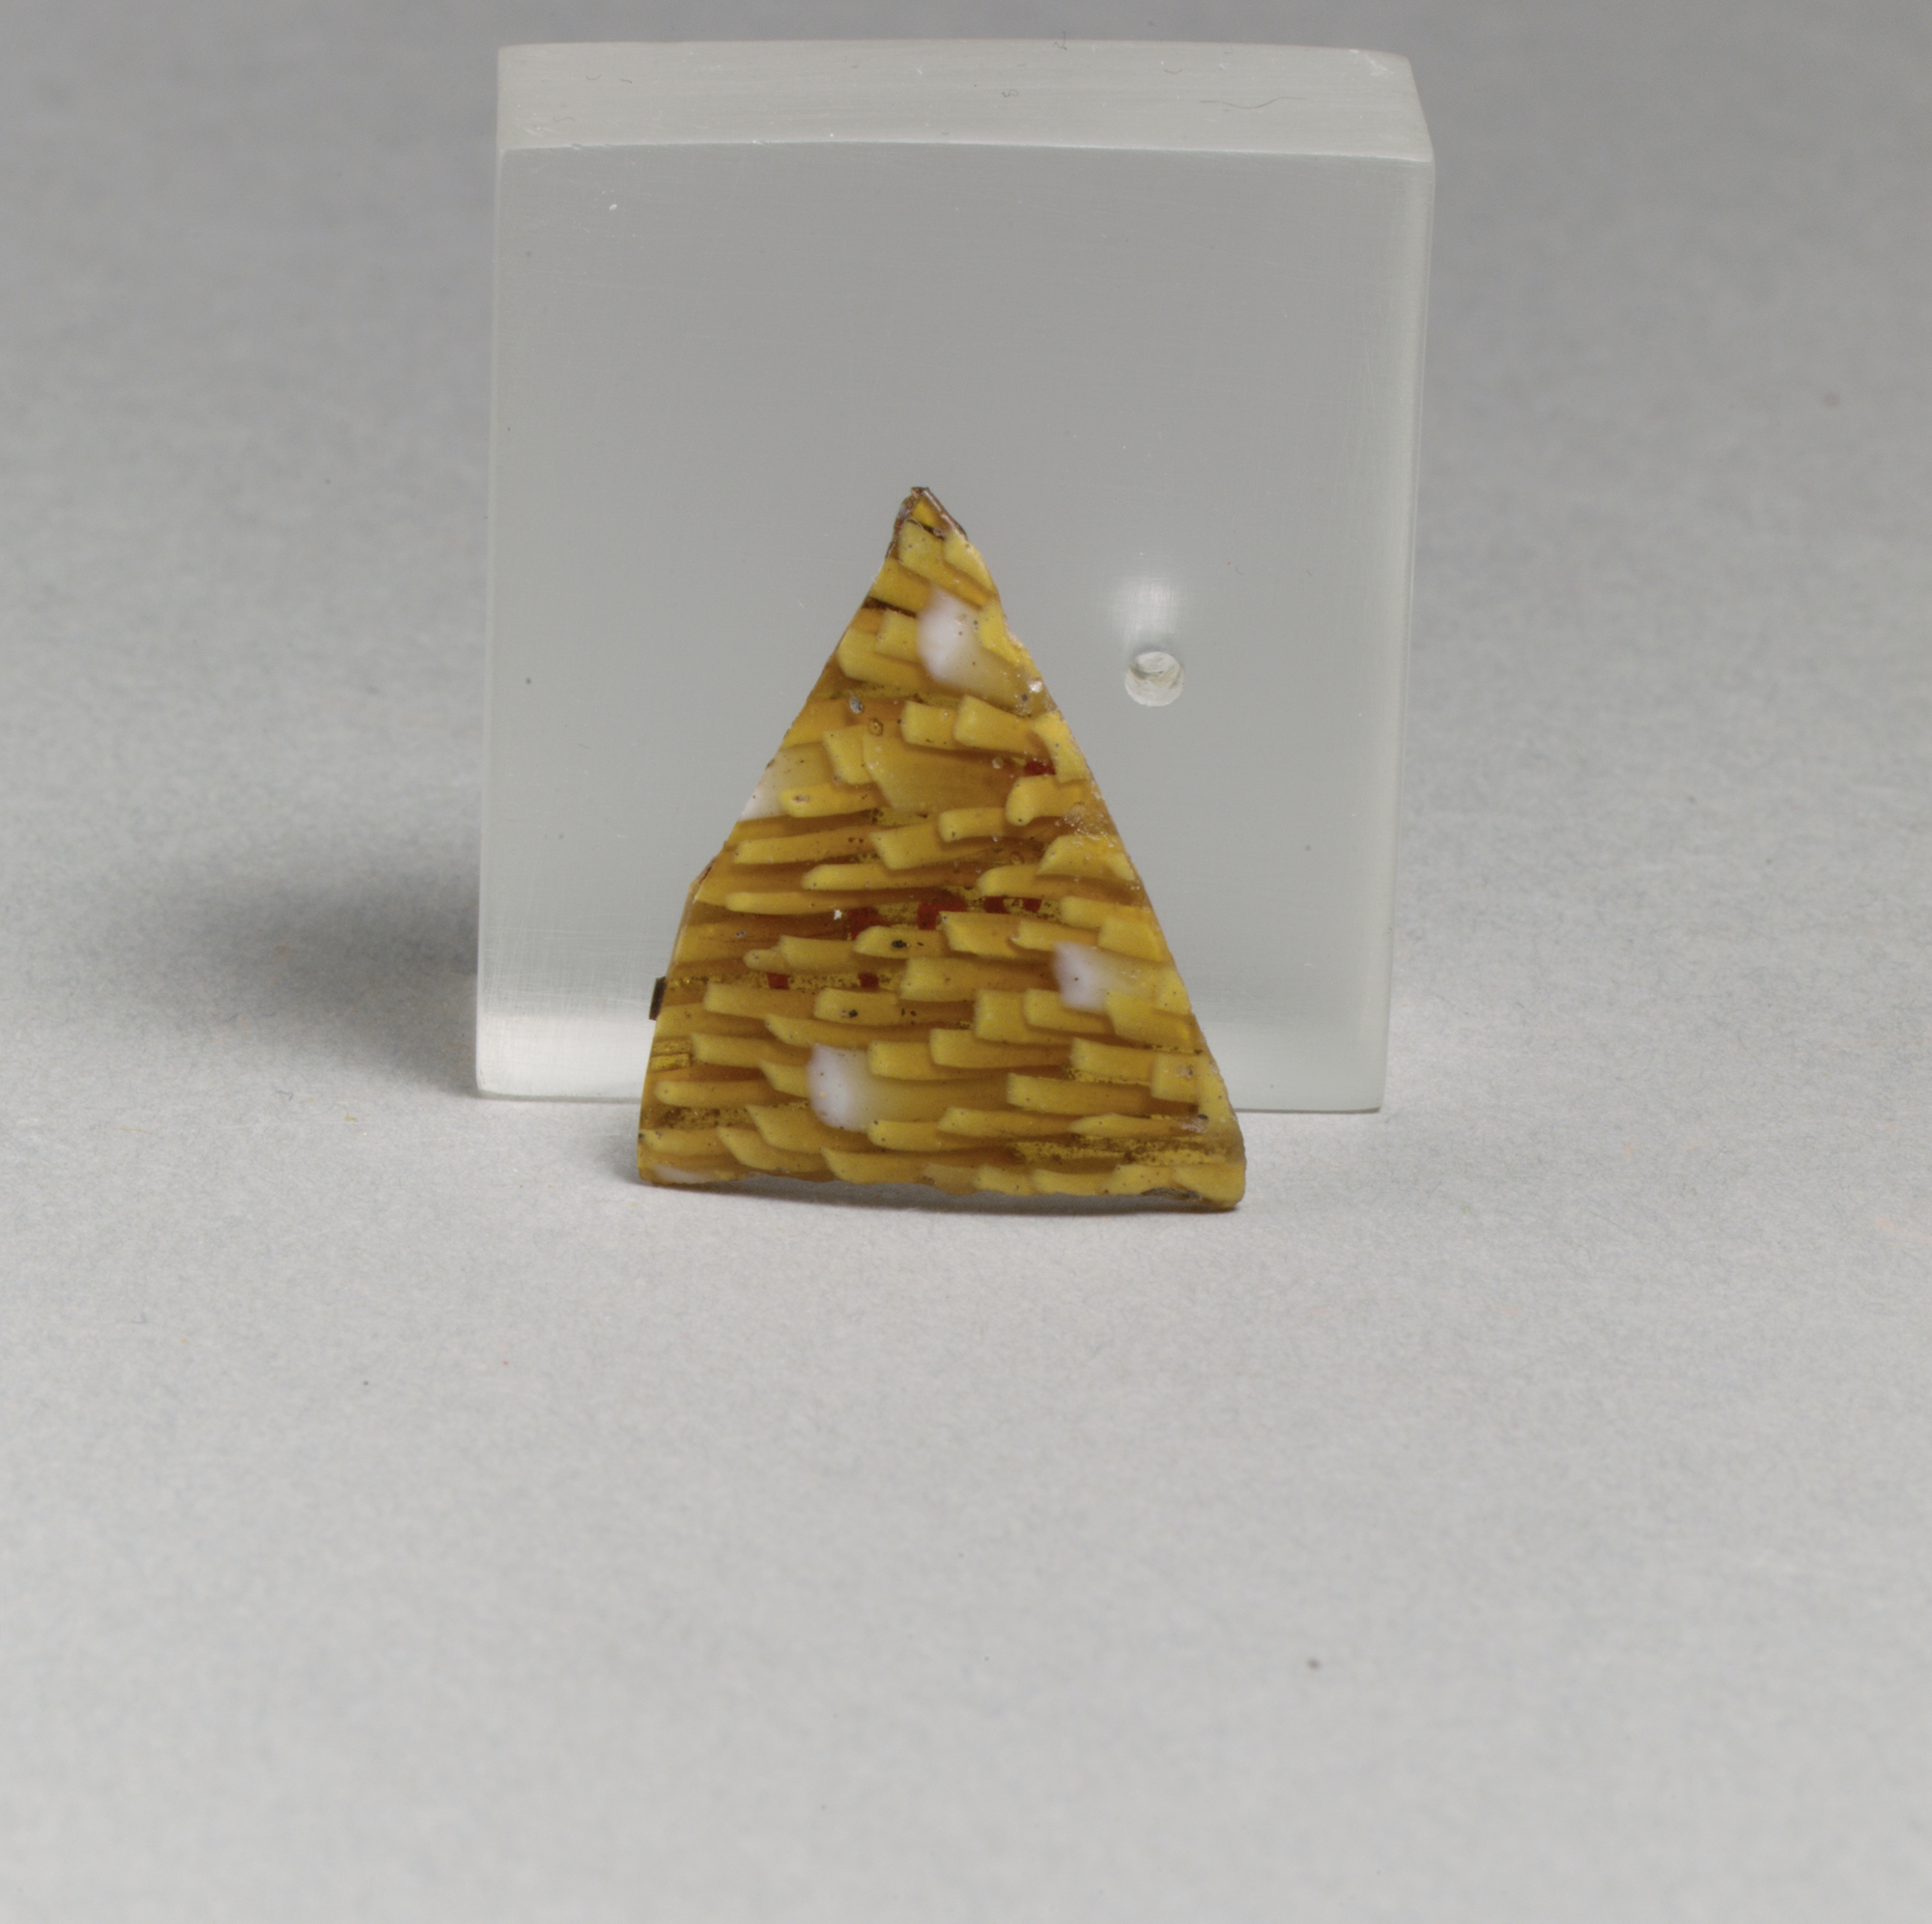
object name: fragment, mosaic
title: Glass mosaic fragment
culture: roman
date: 34 BCE-33 CE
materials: glass